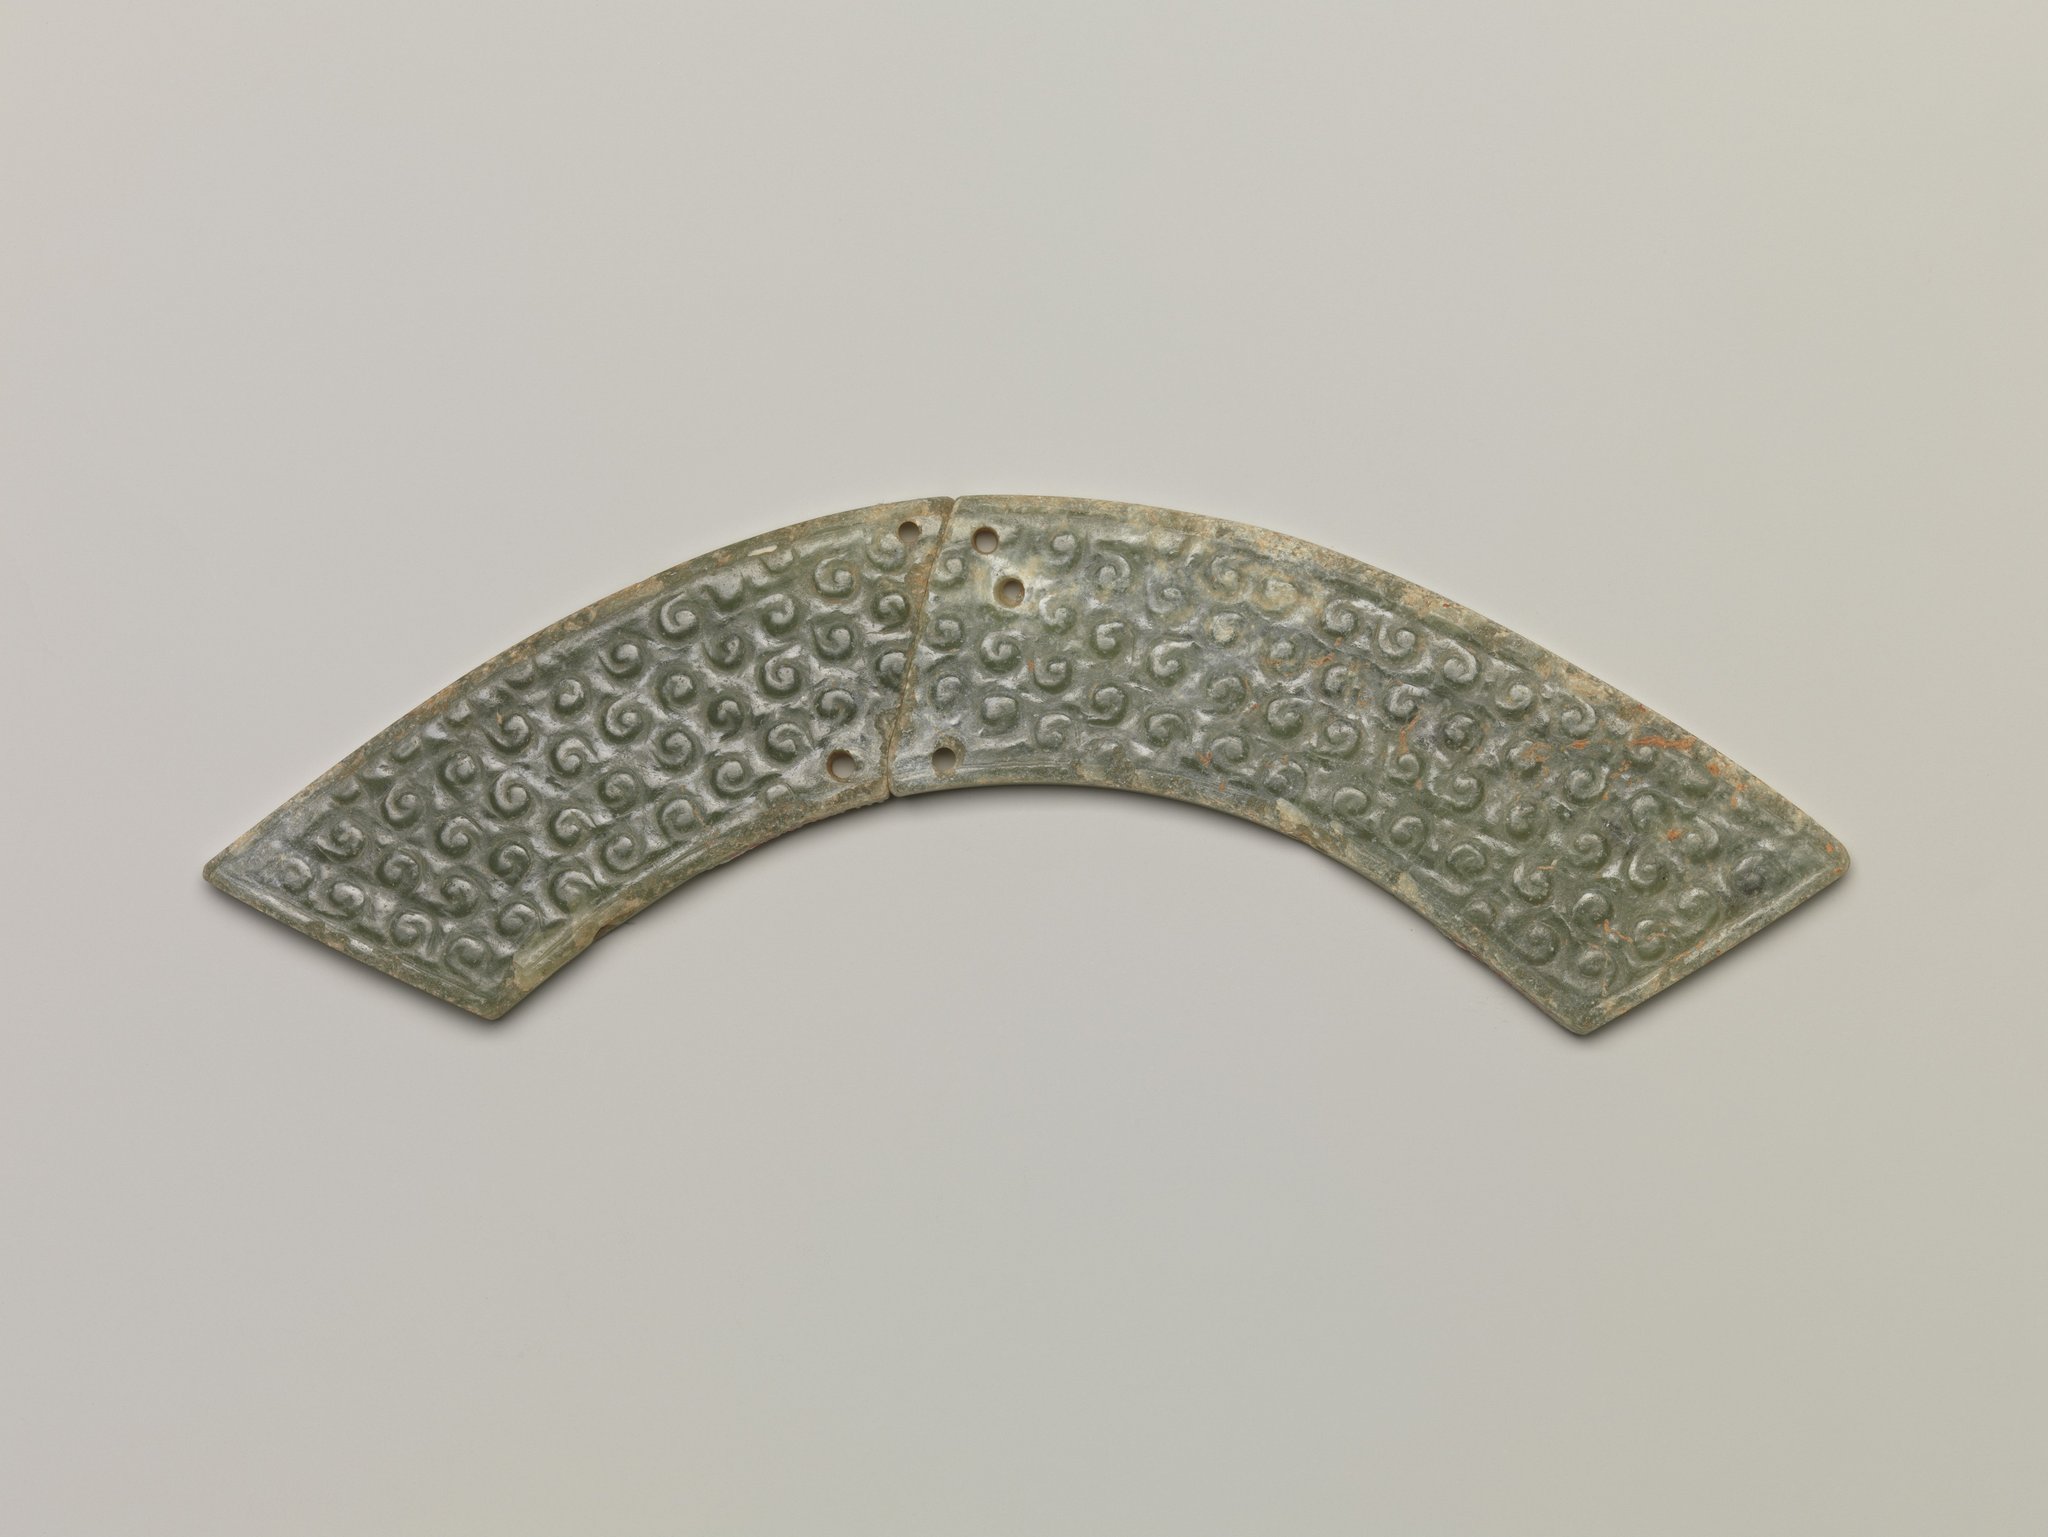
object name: pendant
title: Arc-shaped pendant (Huang)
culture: chinese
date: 500-401 BCE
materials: jade